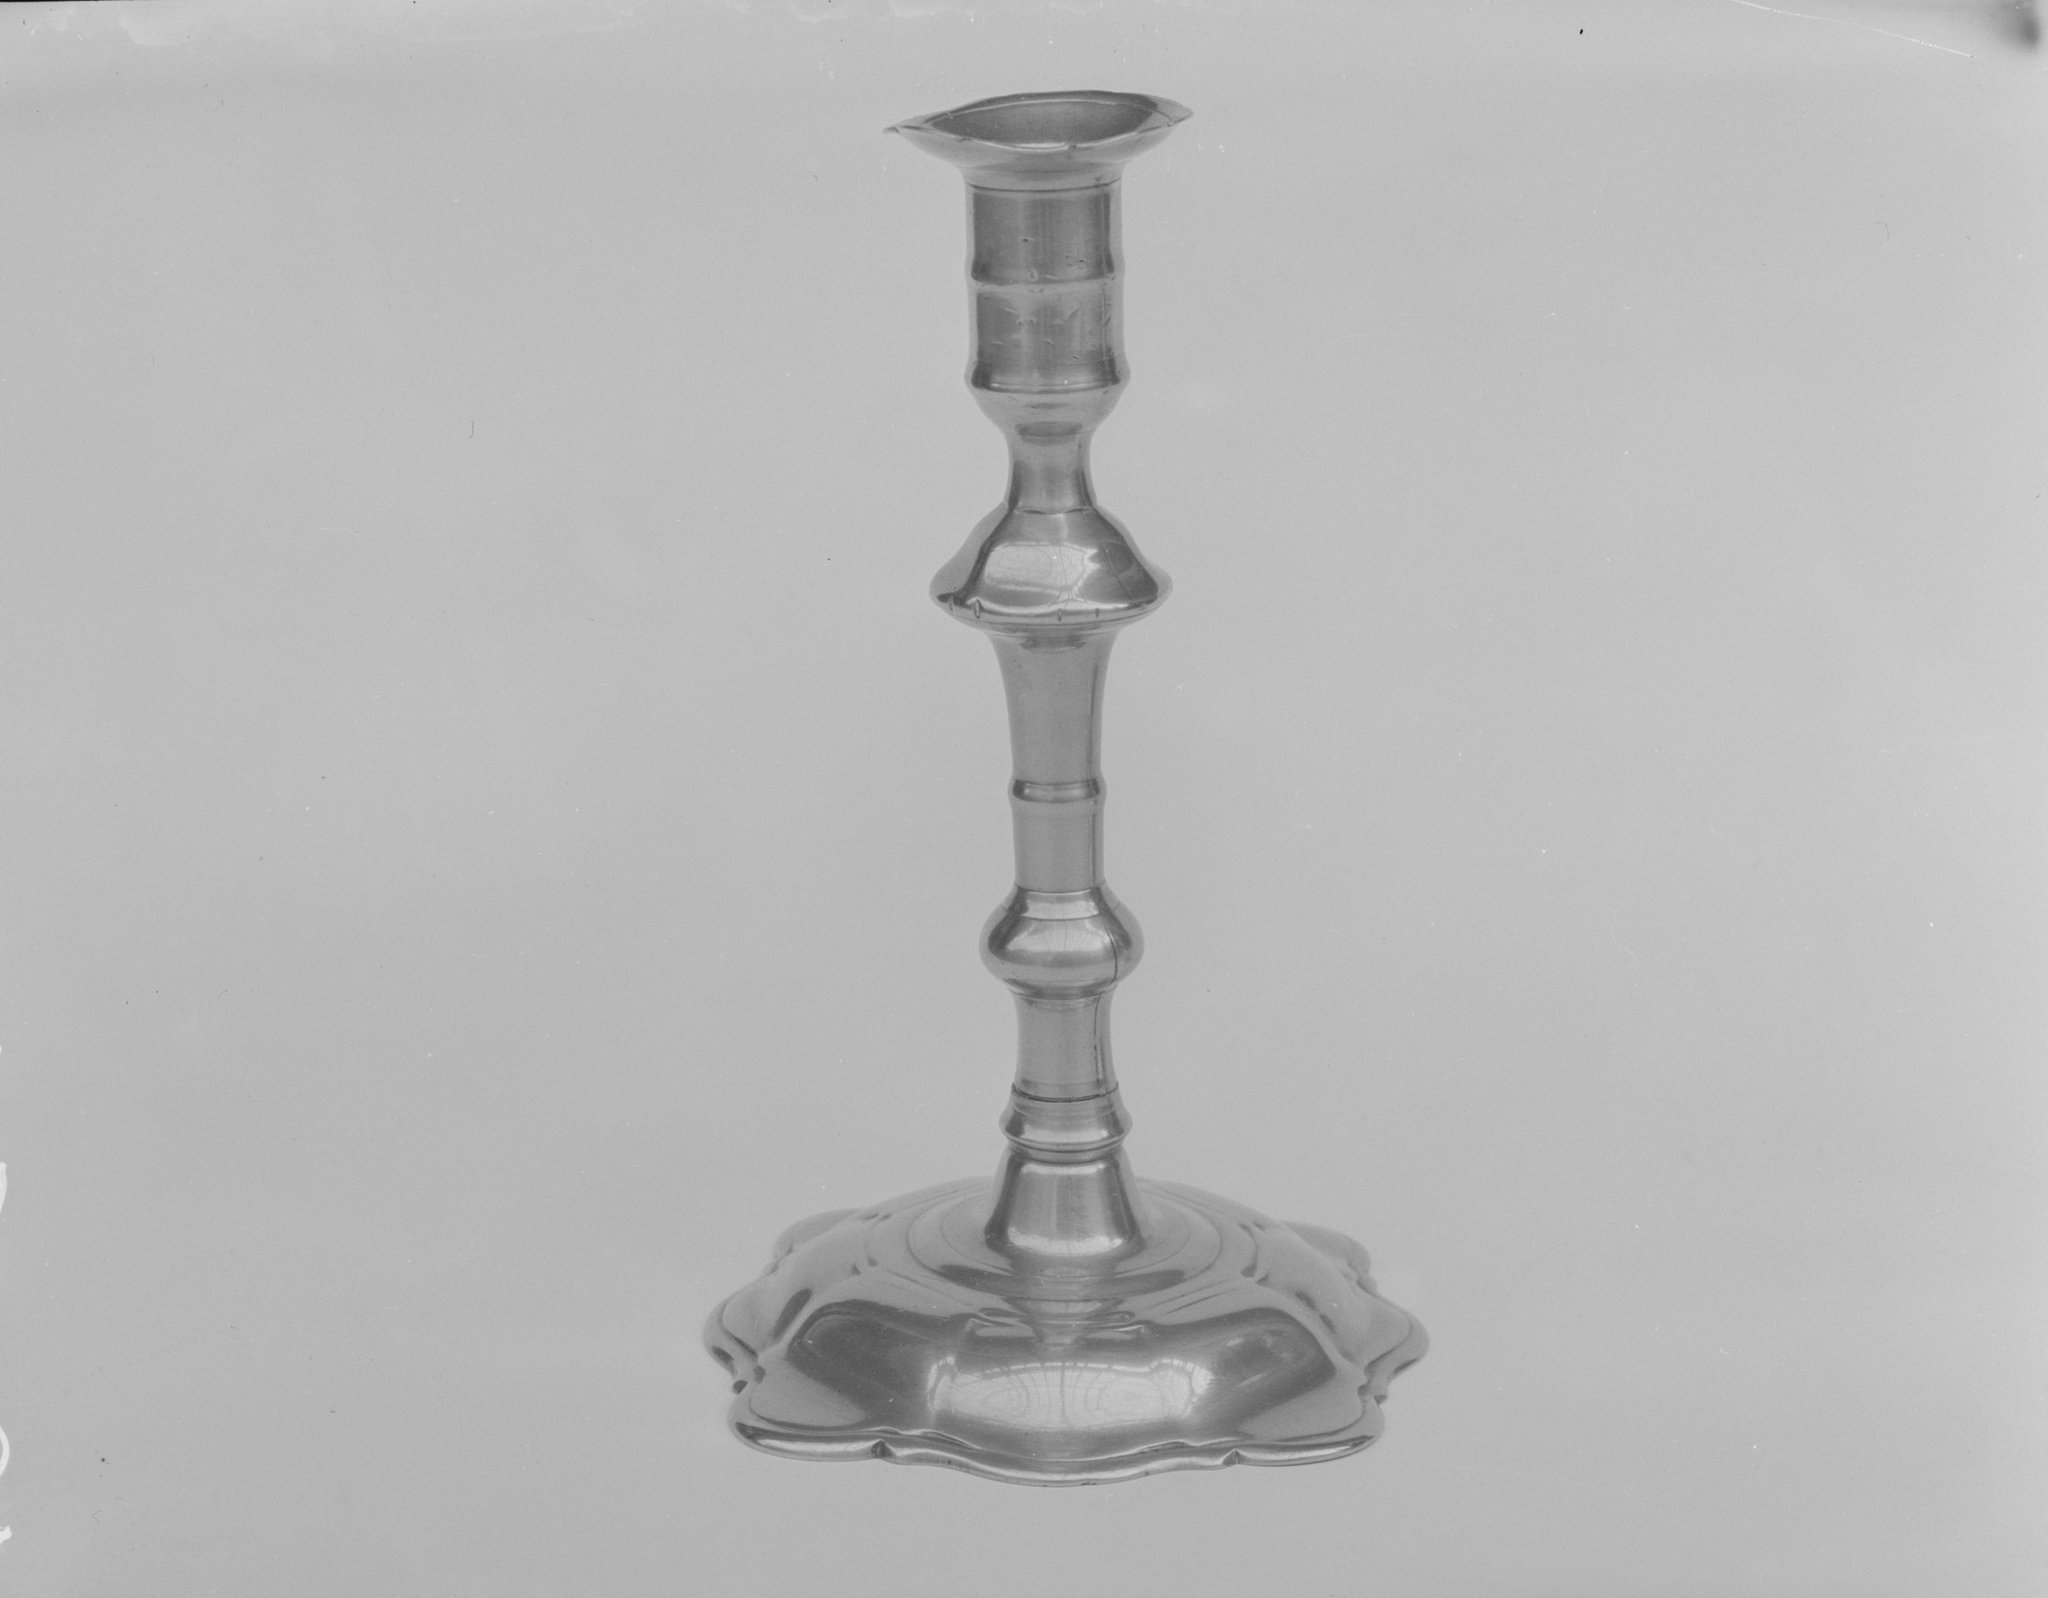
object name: candlestick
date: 1740-1770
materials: brass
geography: england